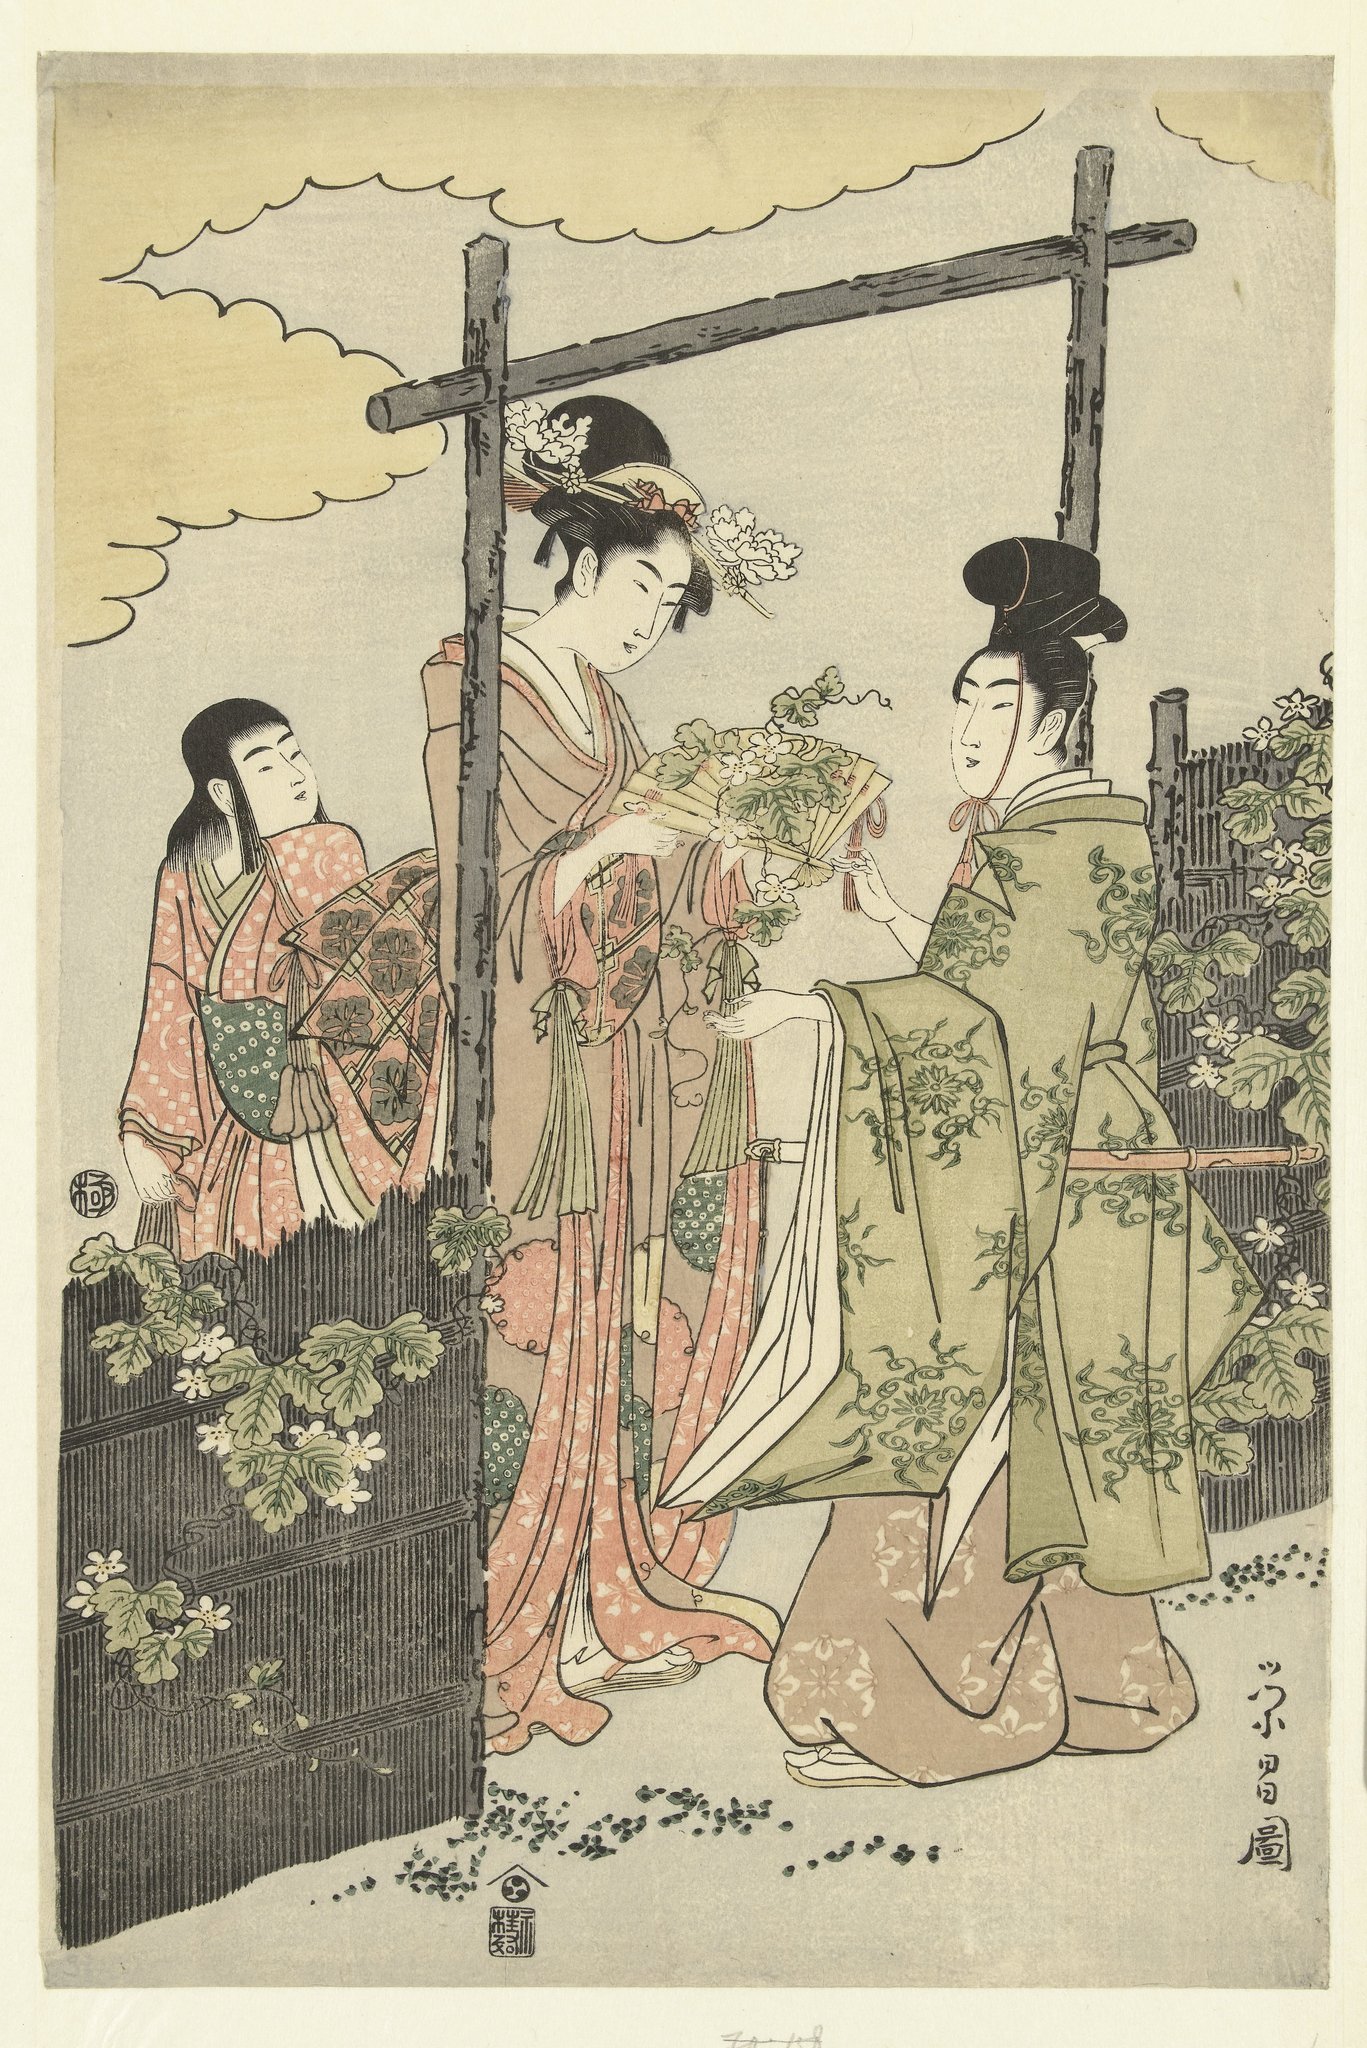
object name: print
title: Prins Genji en Yugao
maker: chokosai eishô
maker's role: print maker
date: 1795-1800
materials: paper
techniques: woodcut, nishiki e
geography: tokyo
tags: fan, gate, entrance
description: Rijk geklede dame, met waaier waarop bloemen, bij poort pratend met hoveling. Toekijkend meisje op de achtergrond; onder geel wolkpatroon.